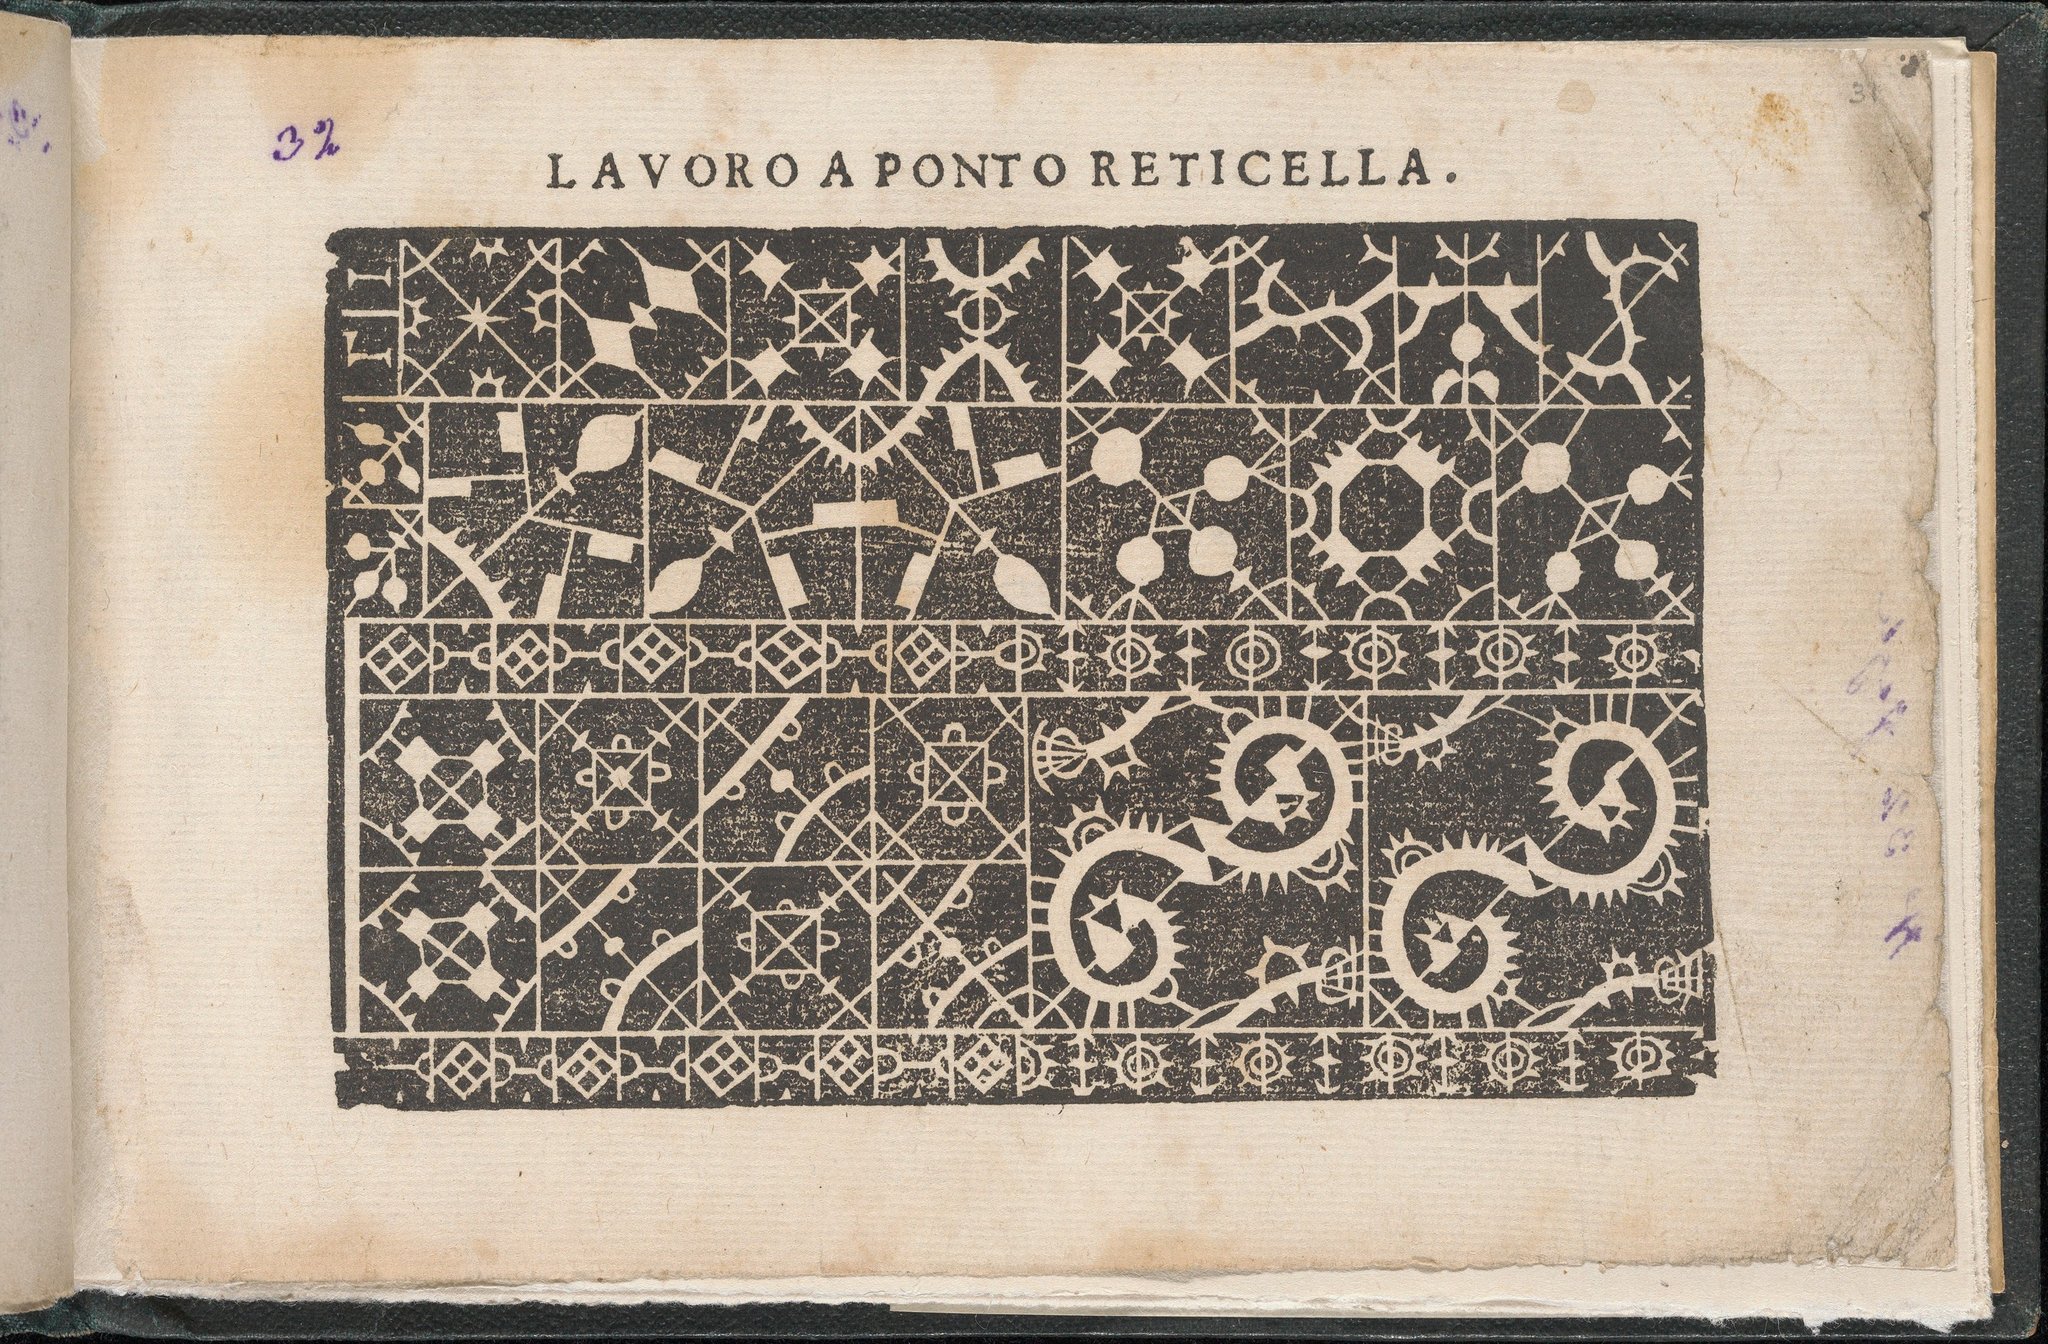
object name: book print ornament architecture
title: Gemma pretiosa della virtuose donne, page 31 (recto)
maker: isabella catanea parasole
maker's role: designer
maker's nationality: italian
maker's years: 1565-1625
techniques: woodcut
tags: ornament